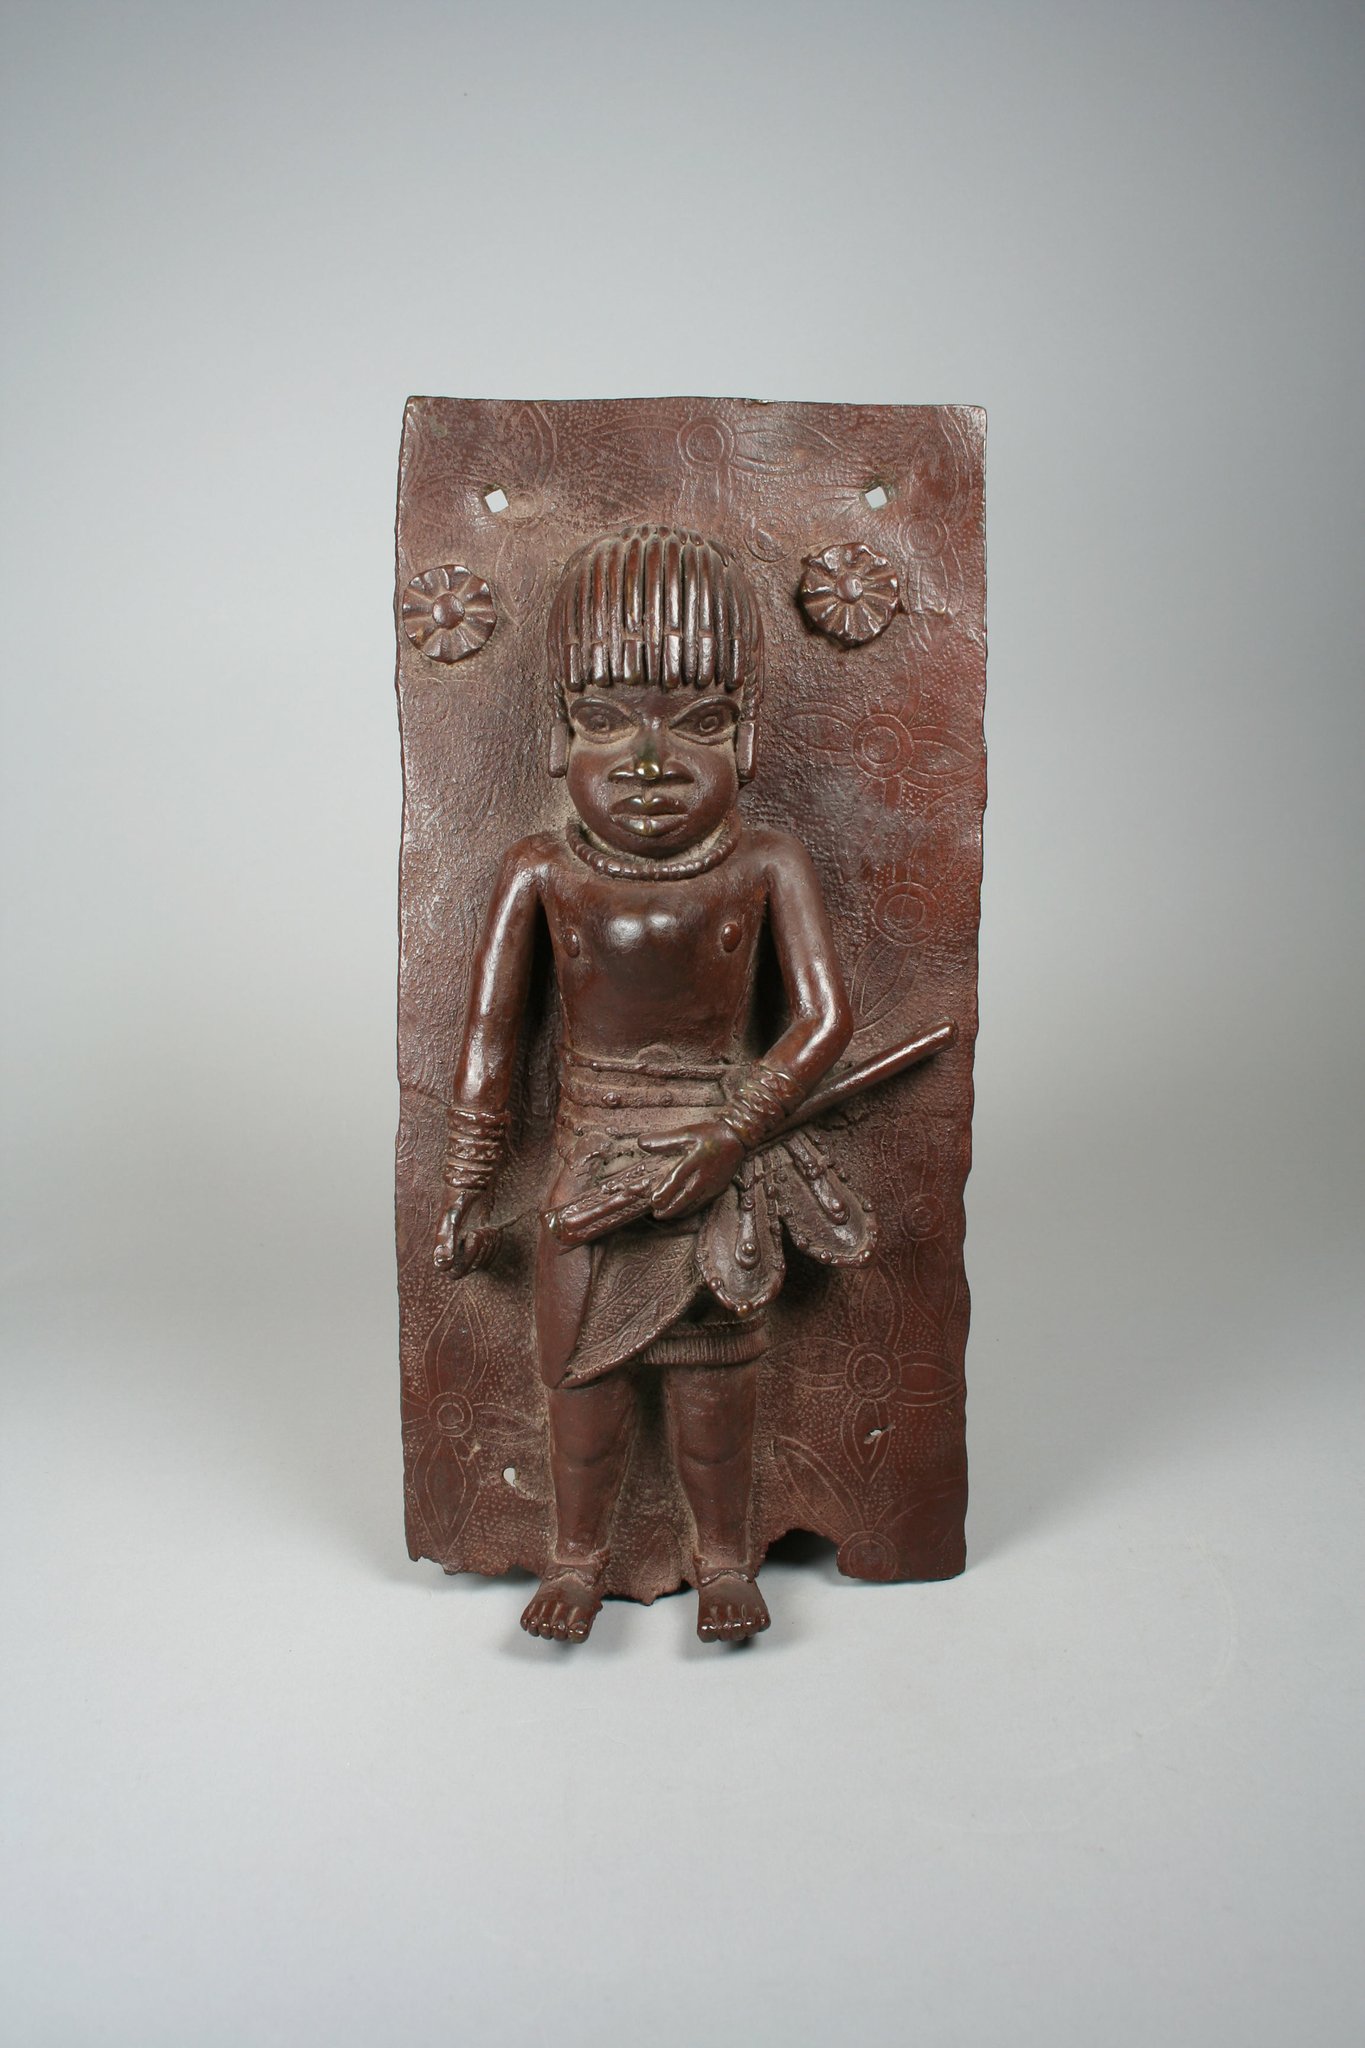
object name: plaque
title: Plaque: Junior Court Official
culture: edo period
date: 1501-1700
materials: brass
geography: nigeria